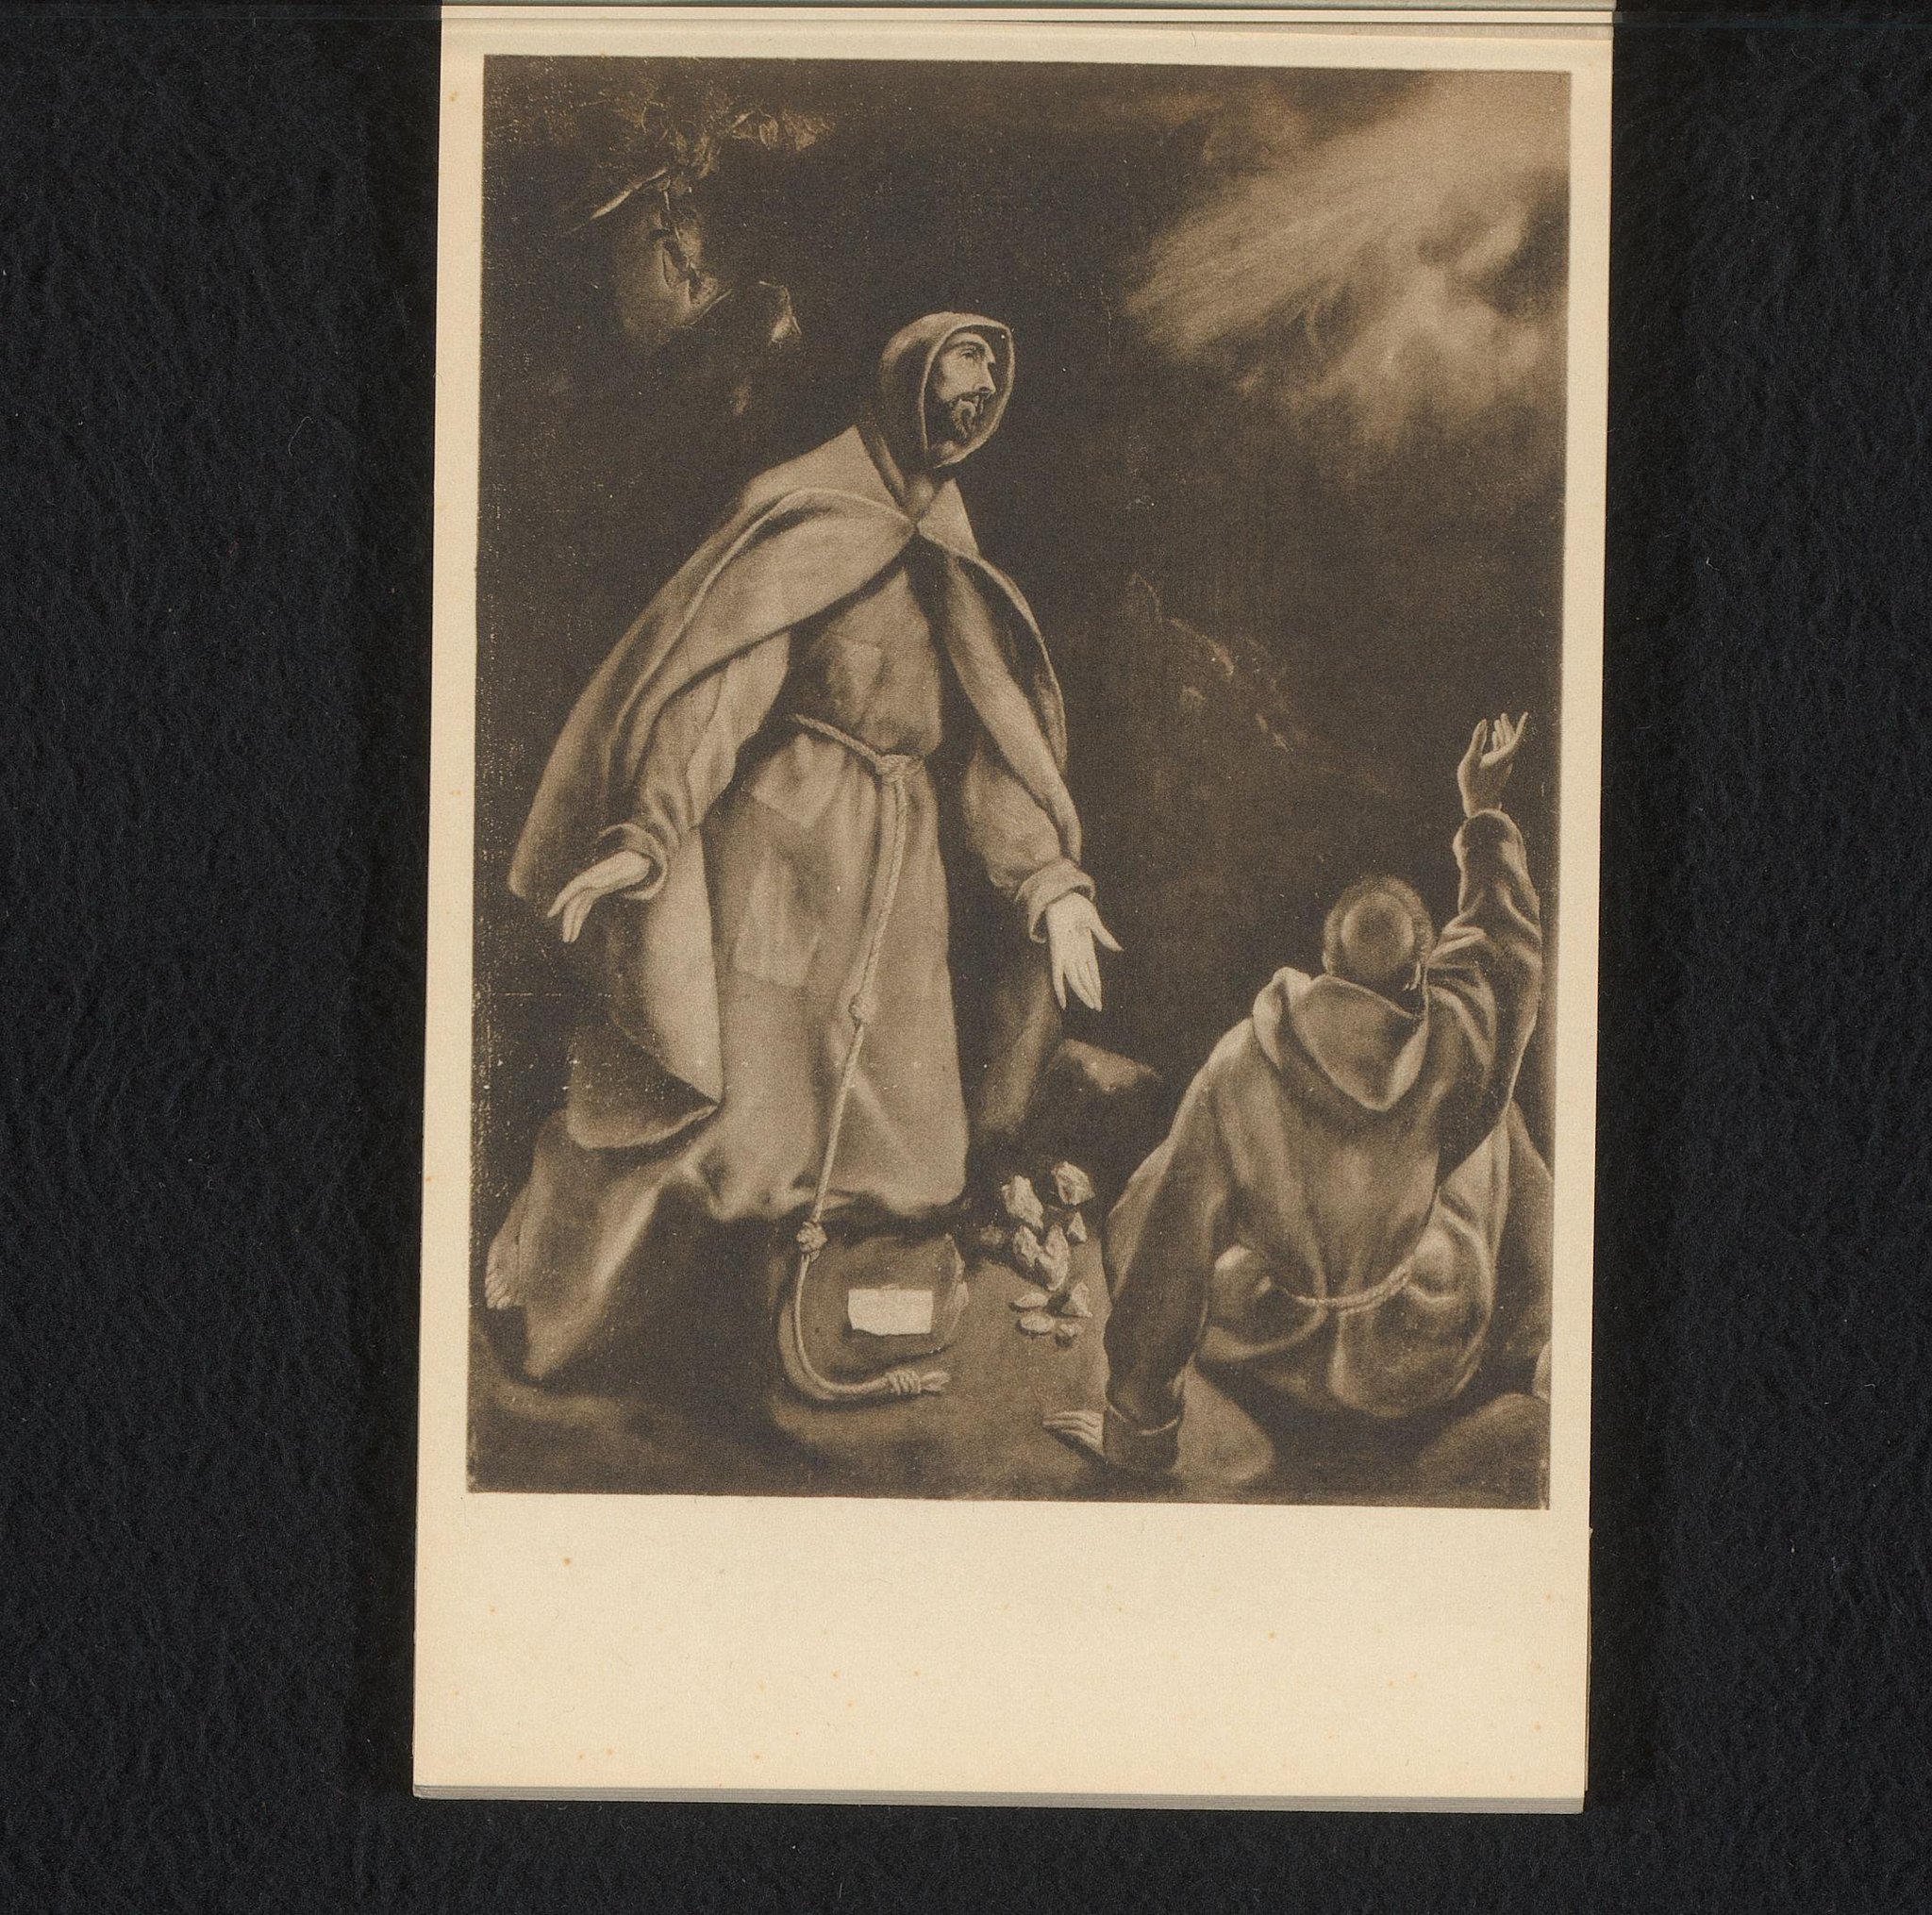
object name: photomechanical print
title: Museo Cerralbo. Madrid. San Francisco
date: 1924-1930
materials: cardboard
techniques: photograph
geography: madrid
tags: permanent exhibition, museum, picture, painting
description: Prentbriefkaart maakt deel uit van een album.